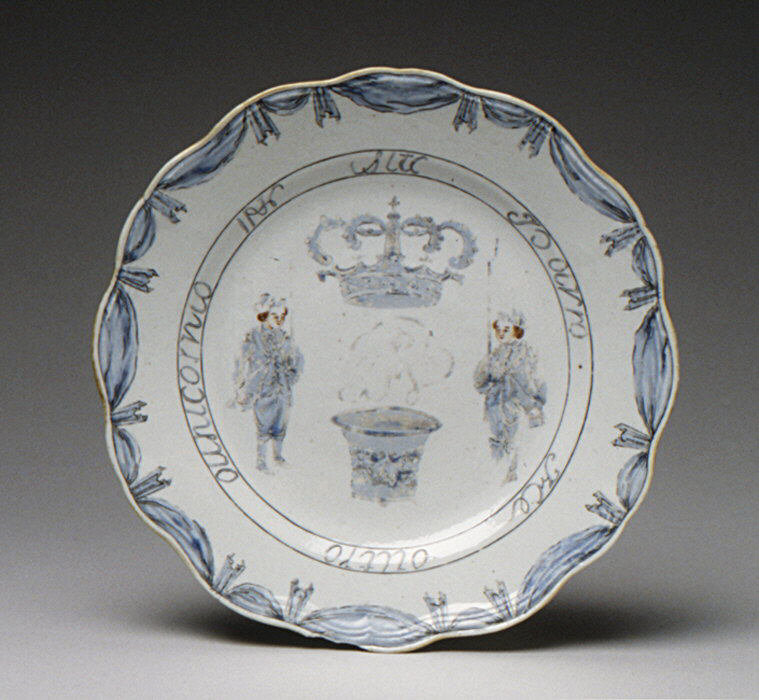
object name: plate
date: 1776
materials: hard paste porcelain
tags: men,insignia